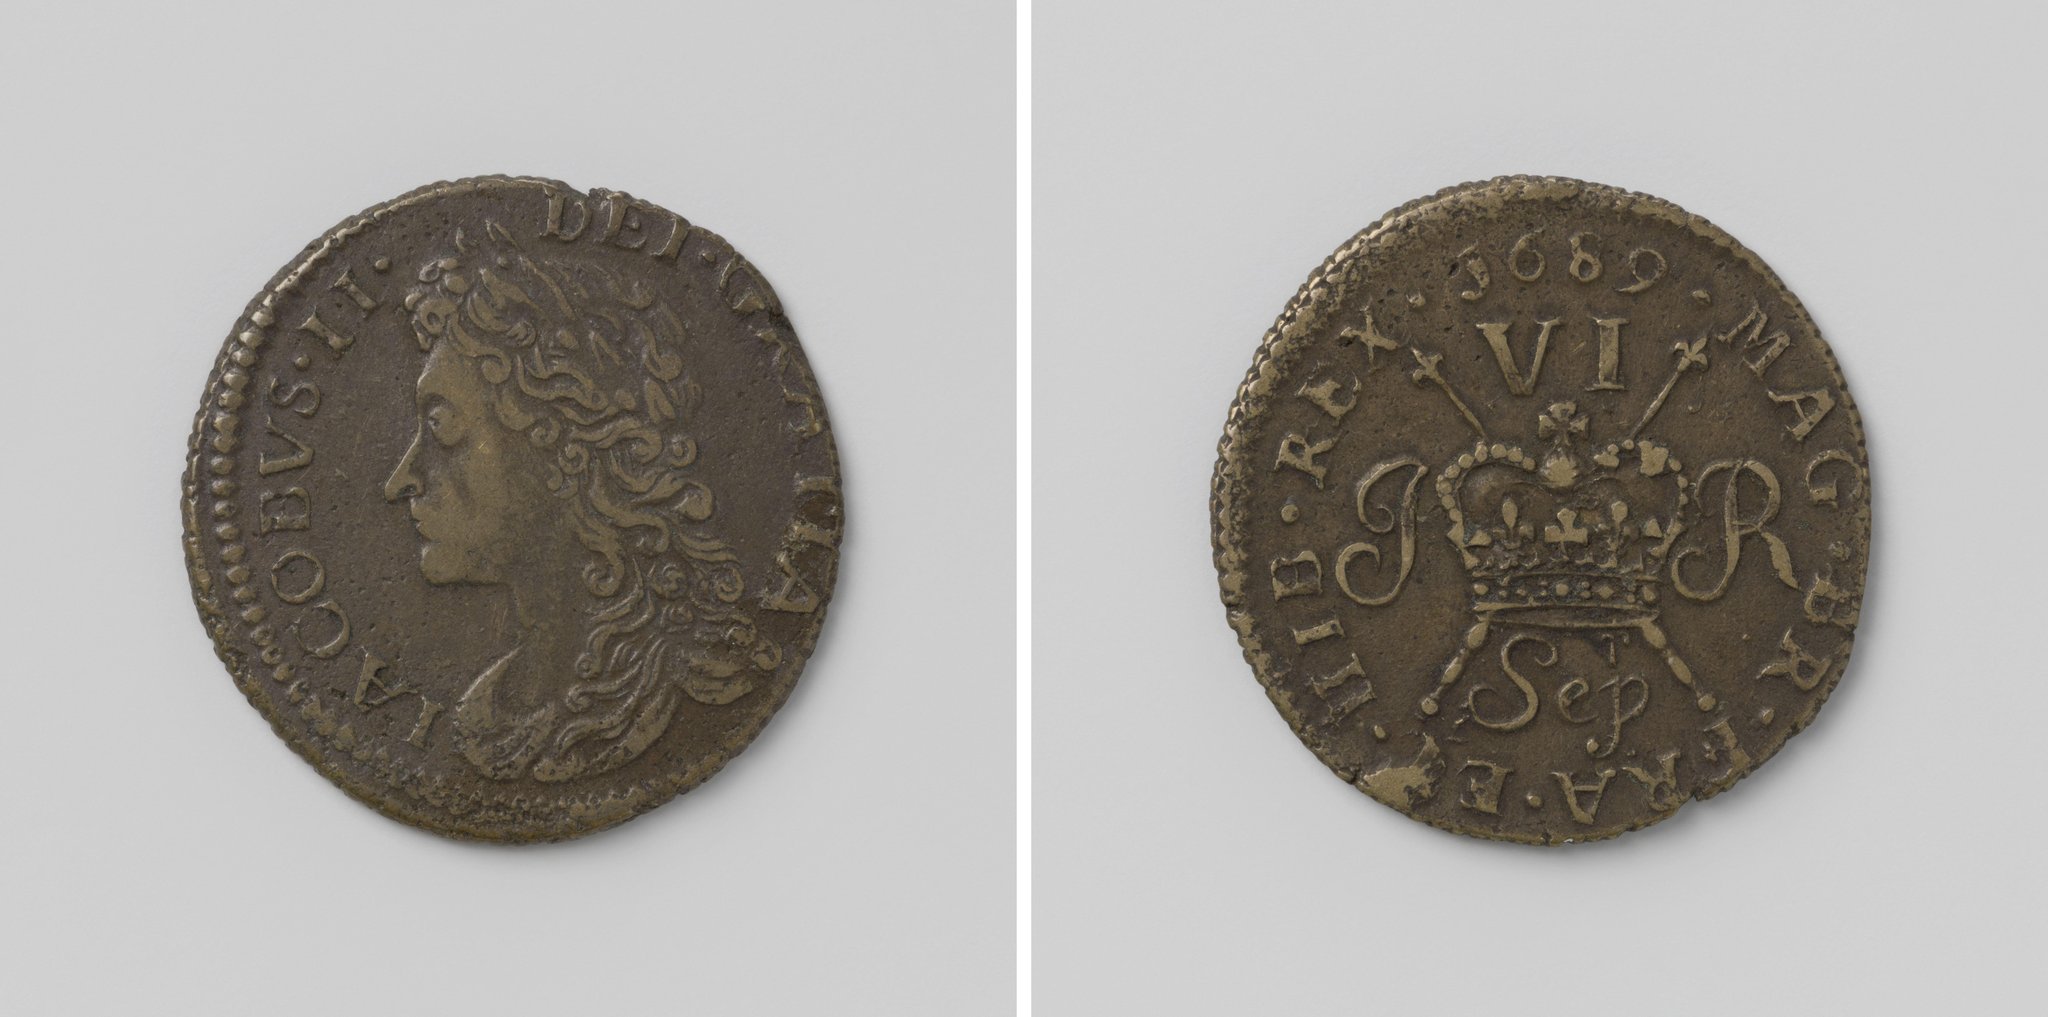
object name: coin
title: Zes pence, noodmunt van Jacobus II, koning van Engeland, uit september 1689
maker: Anonymous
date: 1609-1689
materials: copper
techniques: striking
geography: ireland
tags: jacobus ii (koning van engeland en schotland)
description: Voorzijde: borststuk man met lauwerkrans binnen omschrift. Keerzijde: kroon, waardoor twee gekruiste scepters steken tussen monogram van letters J en R; boven kroon Romeinse cijfer XXX, onder kroon opschrift "Sept" binnen omschrift